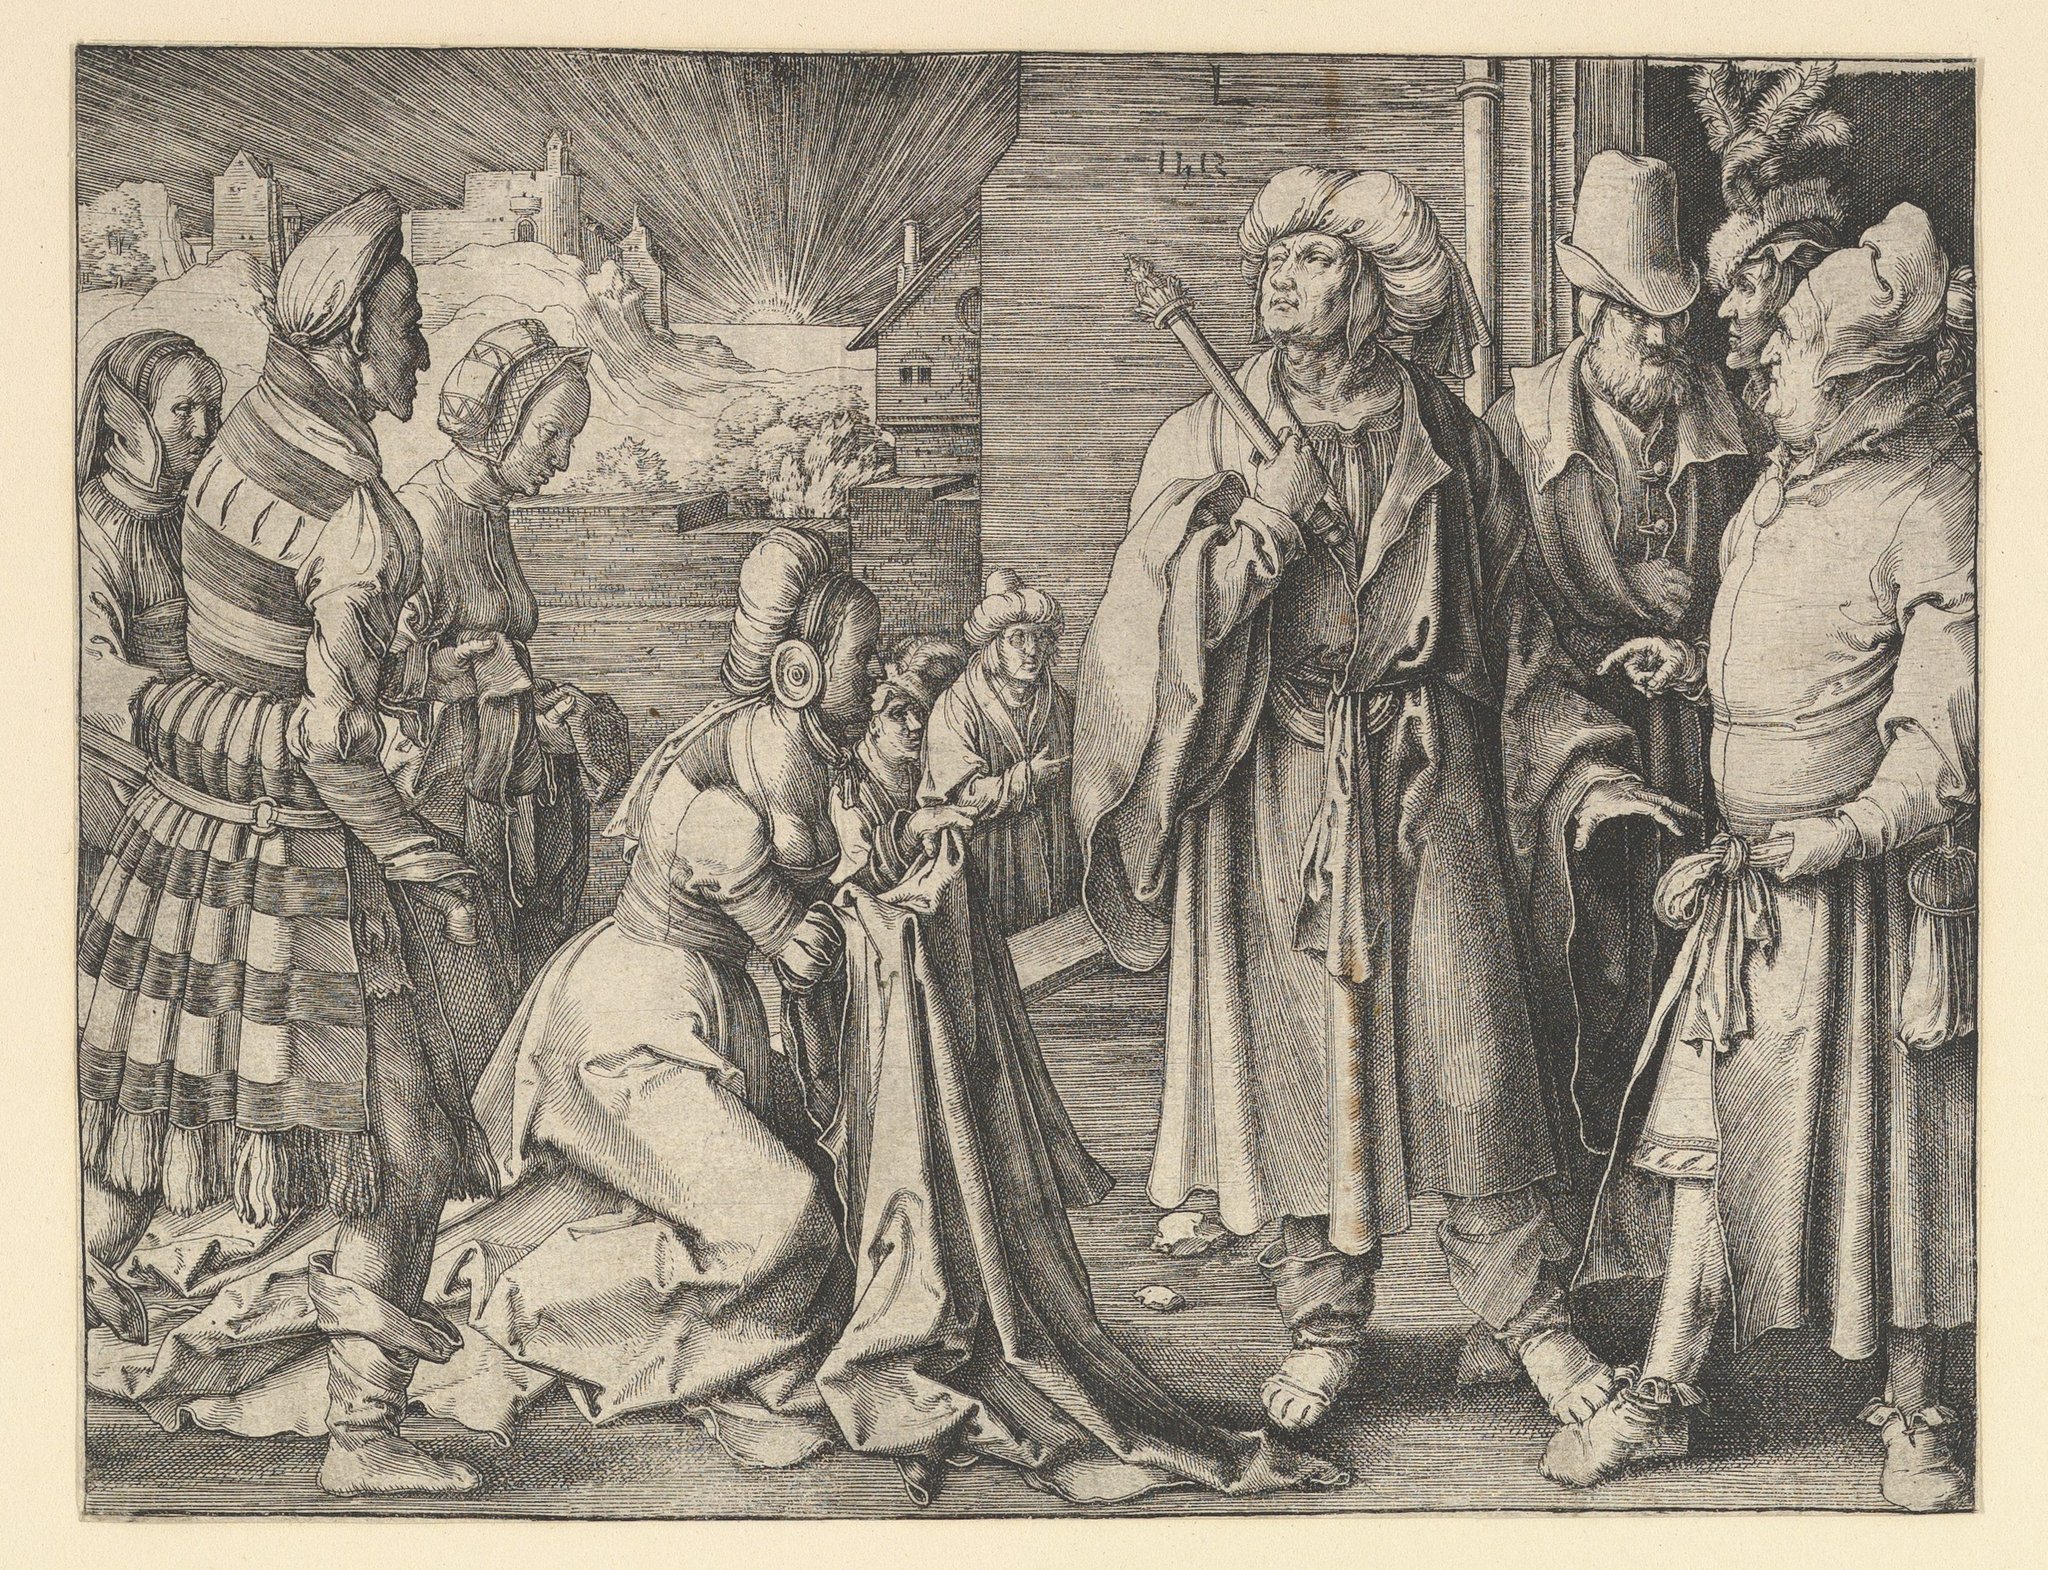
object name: print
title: Potiphar's Wife Acuses Joseph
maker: lucas van leyden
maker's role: artist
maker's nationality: netherlandish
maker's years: 1494-1533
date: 1512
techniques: engraving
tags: men,women